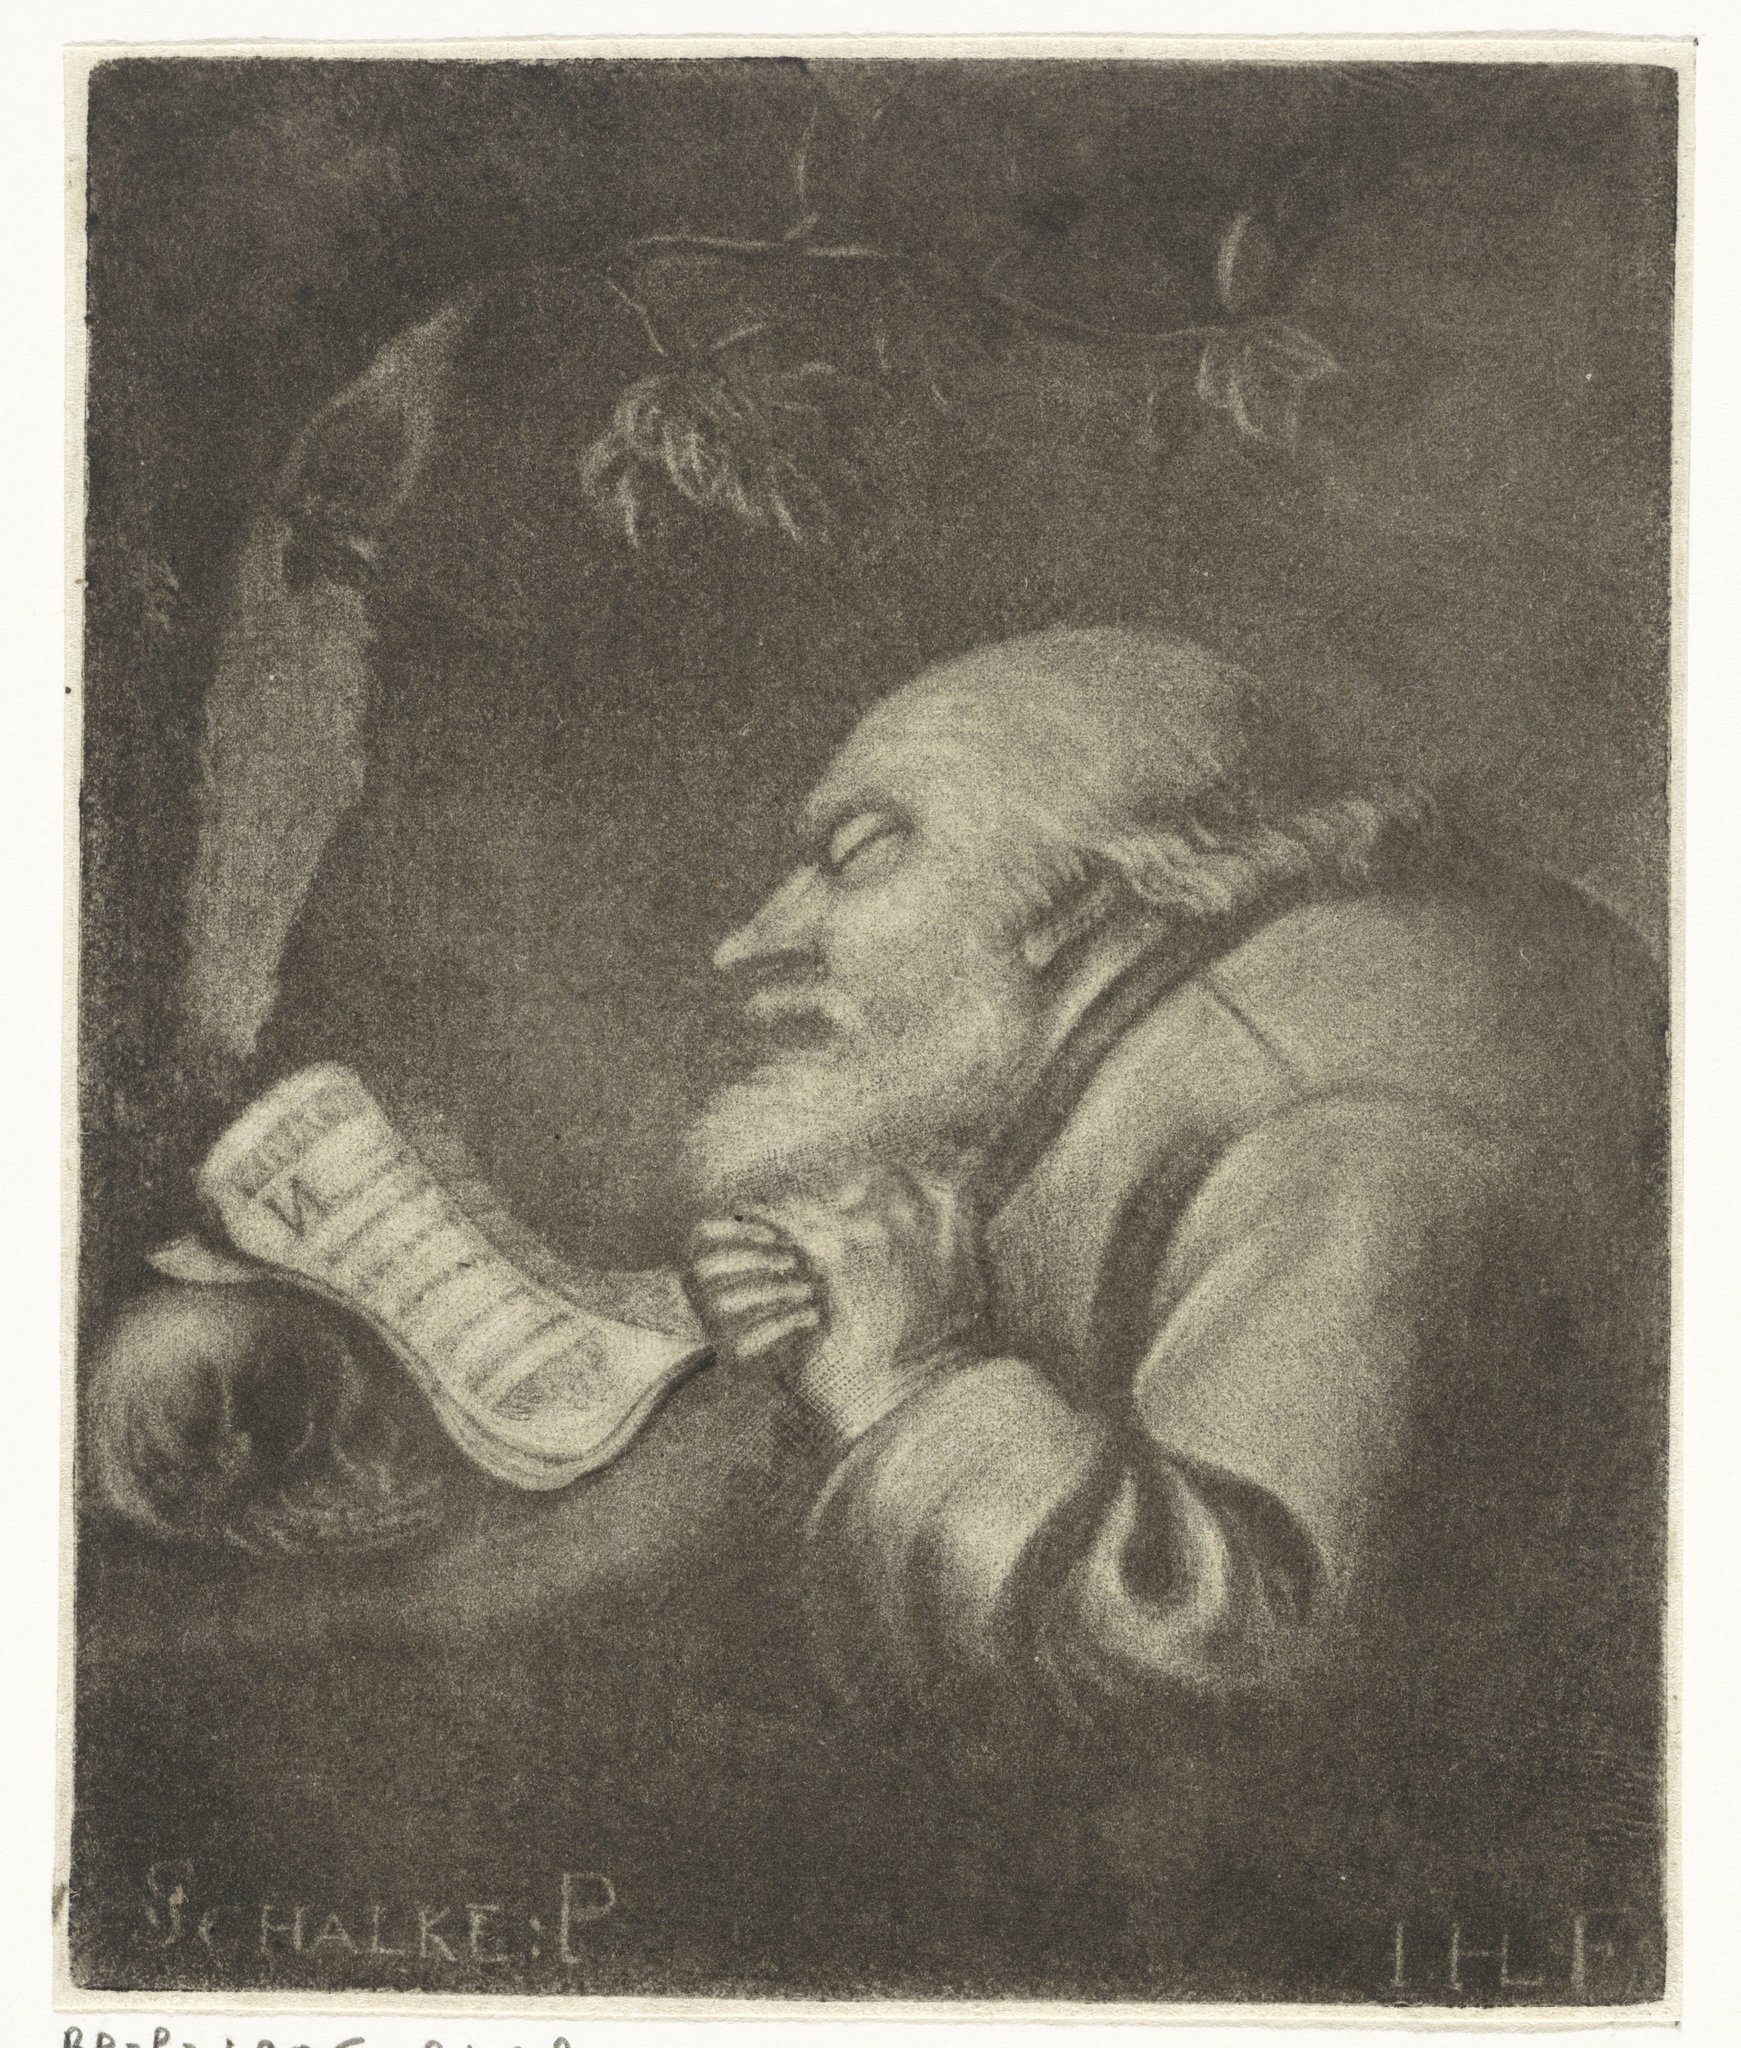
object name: print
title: Biddende monnik, mogelijk de H. Hiëronymus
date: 1723-1789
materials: paper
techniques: mezzotint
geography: dordrecht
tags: (human) skull, monk(s), friar(s)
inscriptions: collector's mark: Lugt 2228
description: Een monnik bidt in de buitenlucht. Voor hem liggen een boek en een menselijke schedel.